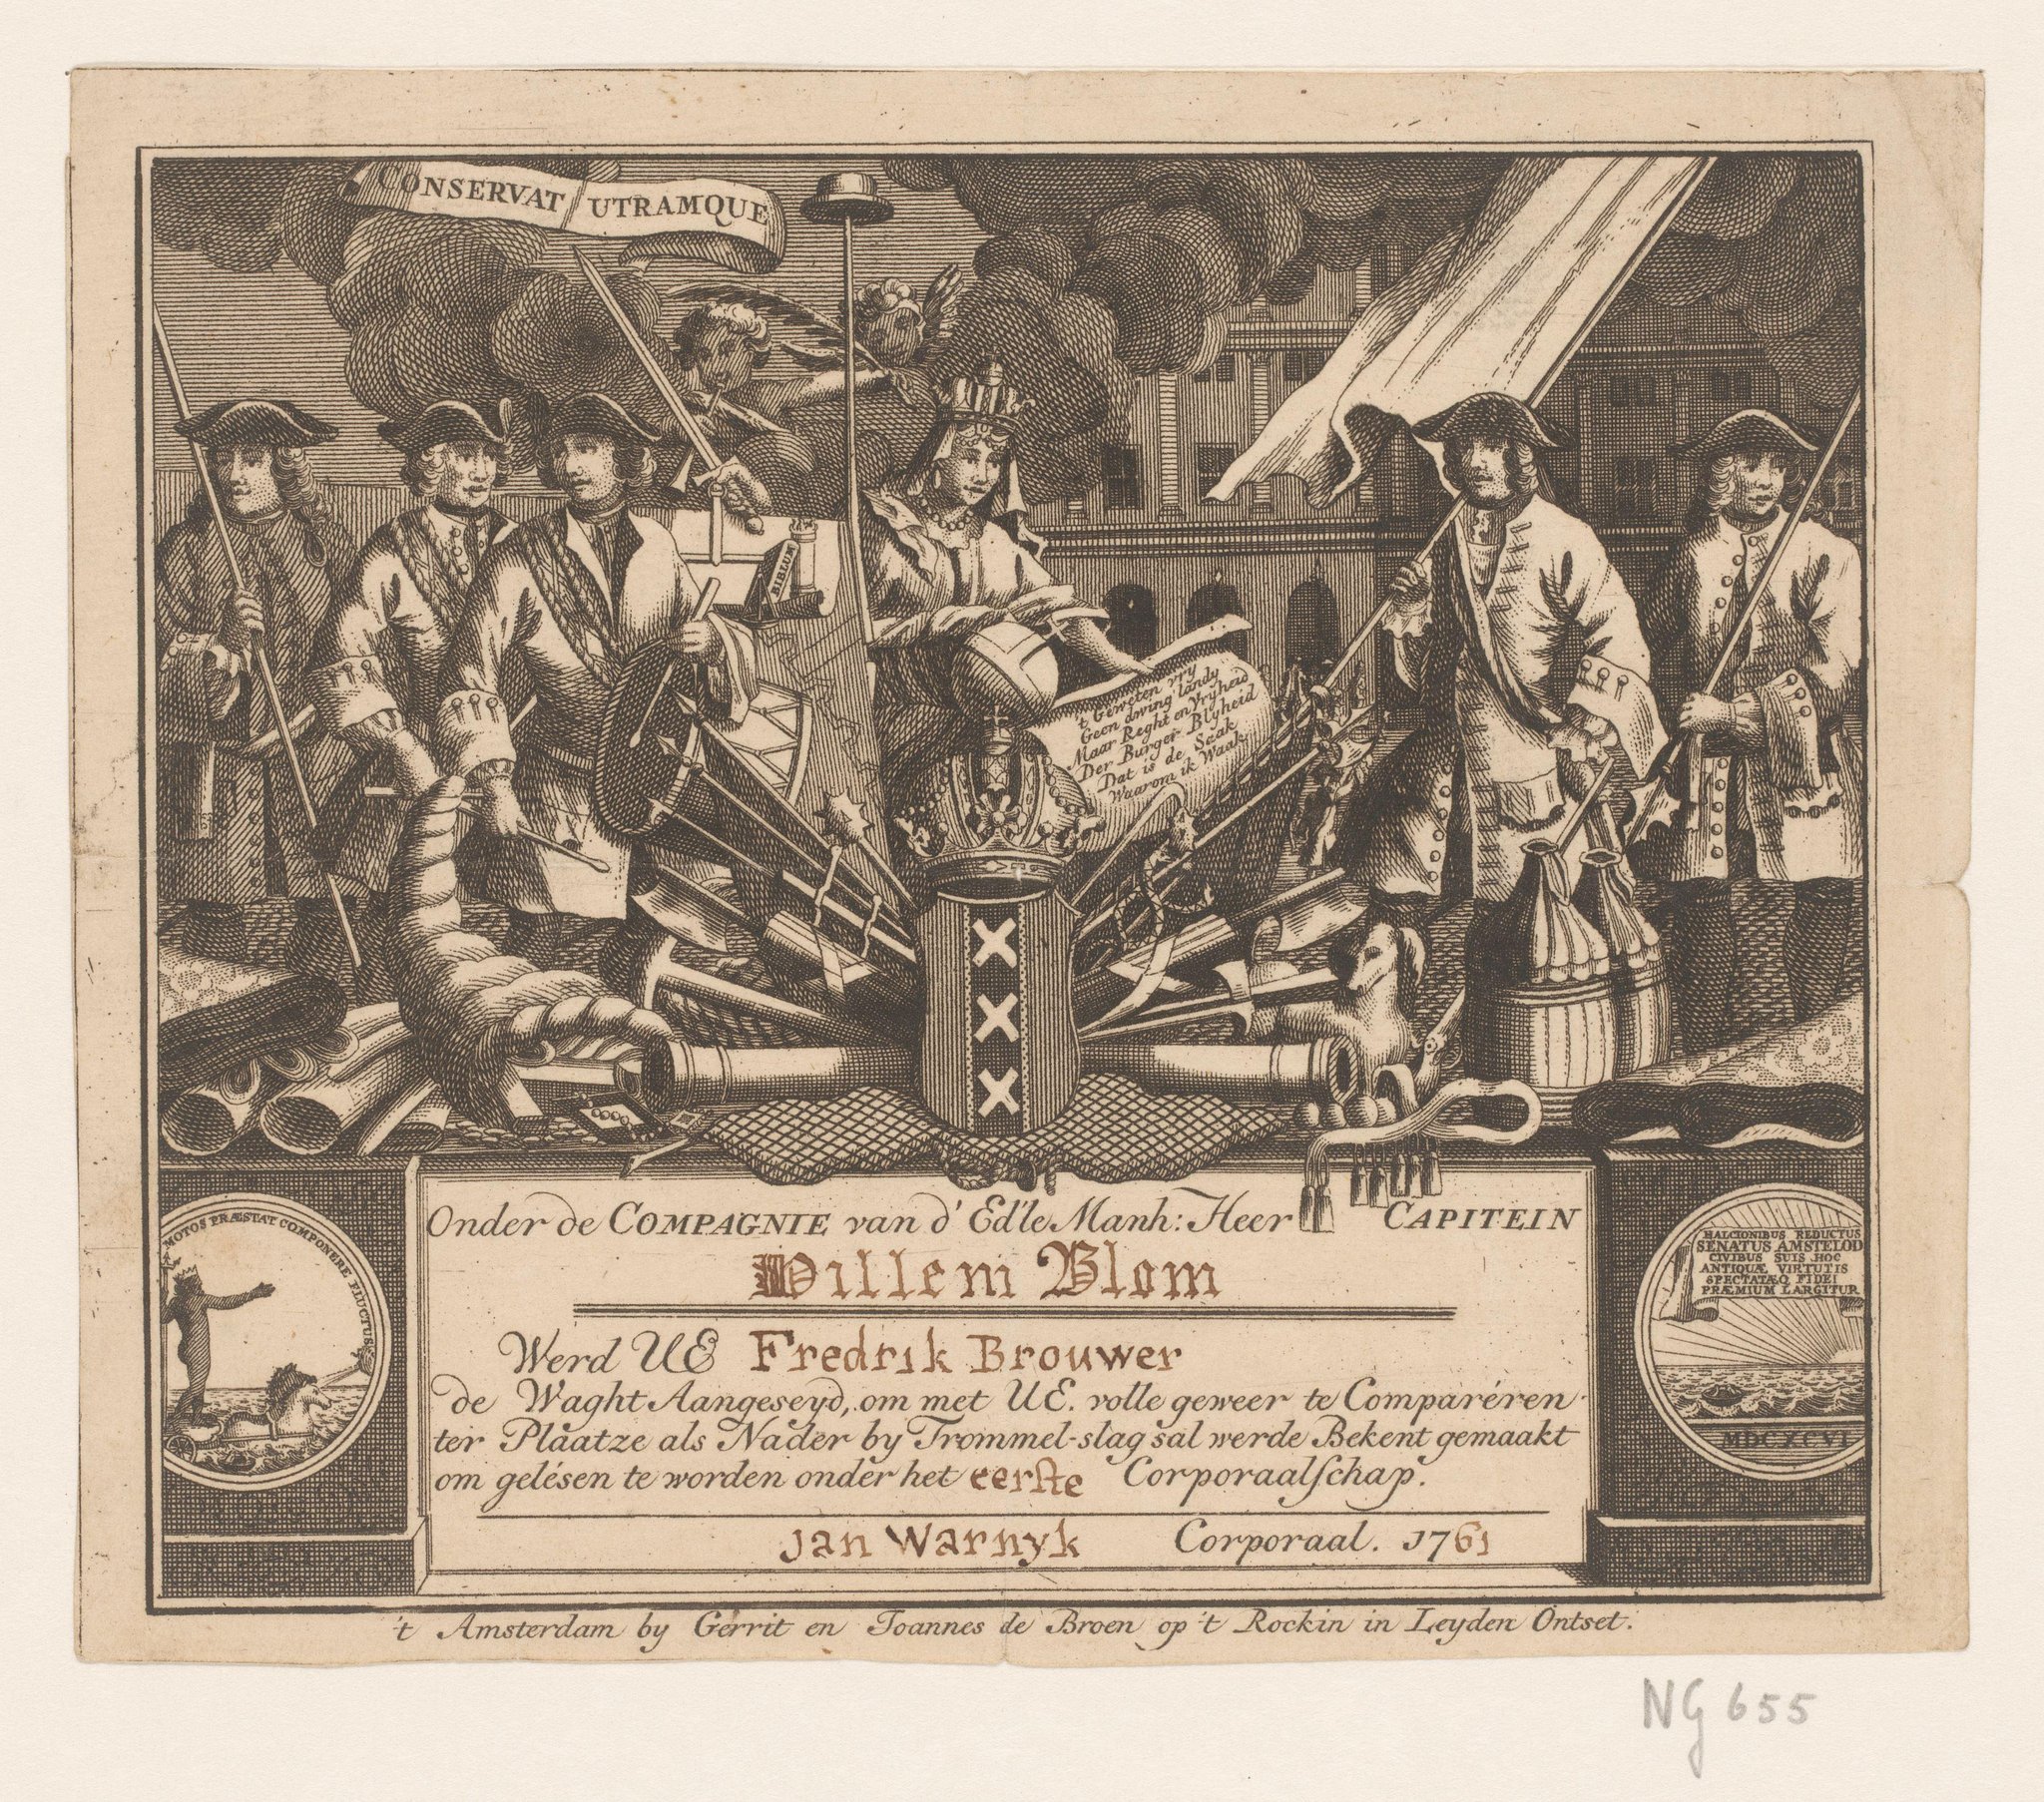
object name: schuttersbiljet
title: Schuttersbrief van kapitein Willem Blom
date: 1761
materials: paper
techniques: etching, writing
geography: amsterdam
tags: personification of a city, town-patron(ess), military service (+ citizen soldiery, civil guard, citizen militia), amsterdam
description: Schuttersbriefje met een oproep gericht aan Frederik Brouwer, van kapitein Willem Blom, om zich bij het eerste korporaalschap van Jan Warnyk van de schutterij te Amsterdam te melden, 1761. Voorgedrukt briefje versierd met soldaten, de stadsmaagd en wapen van Amsterdam met open delen die met de pen zijn ingevuld.